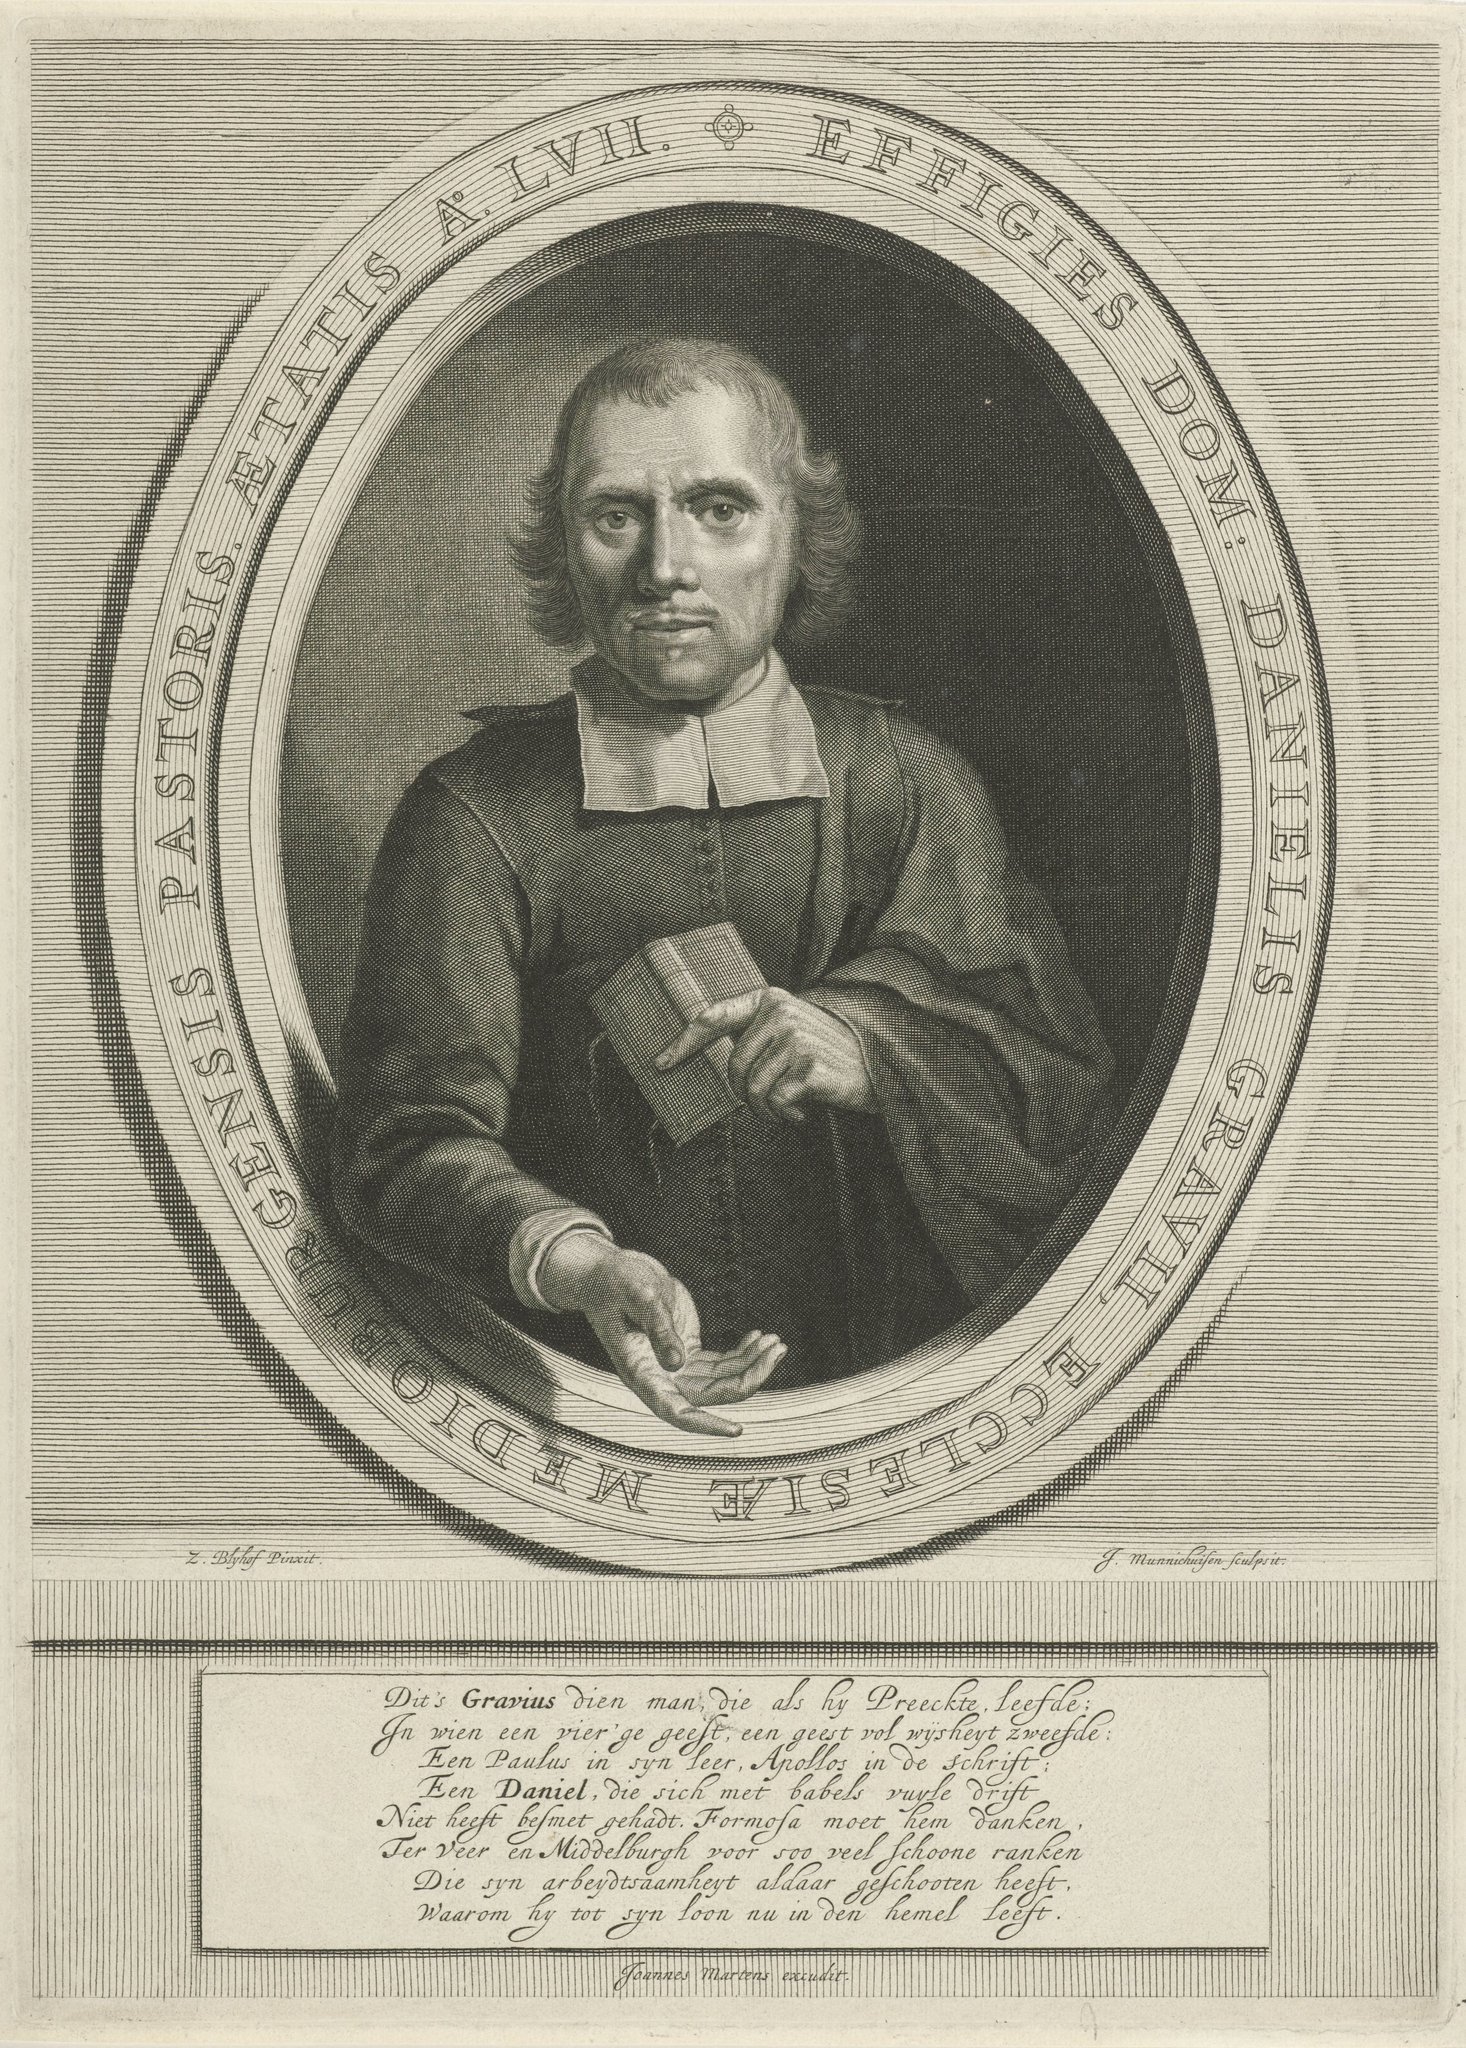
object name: print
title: Portret van Daniël Gravius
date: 1664-1721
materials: paper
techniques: engraving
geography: netherlands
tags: dordrecht, middelburg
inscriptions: collector's mark: Lugt 2228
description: Portret van Daniël Gravius, predikant te Middelburg, met een Bijbel in zijn hand. Onderaan in de marge een achtregelig vers in het Nederlands.